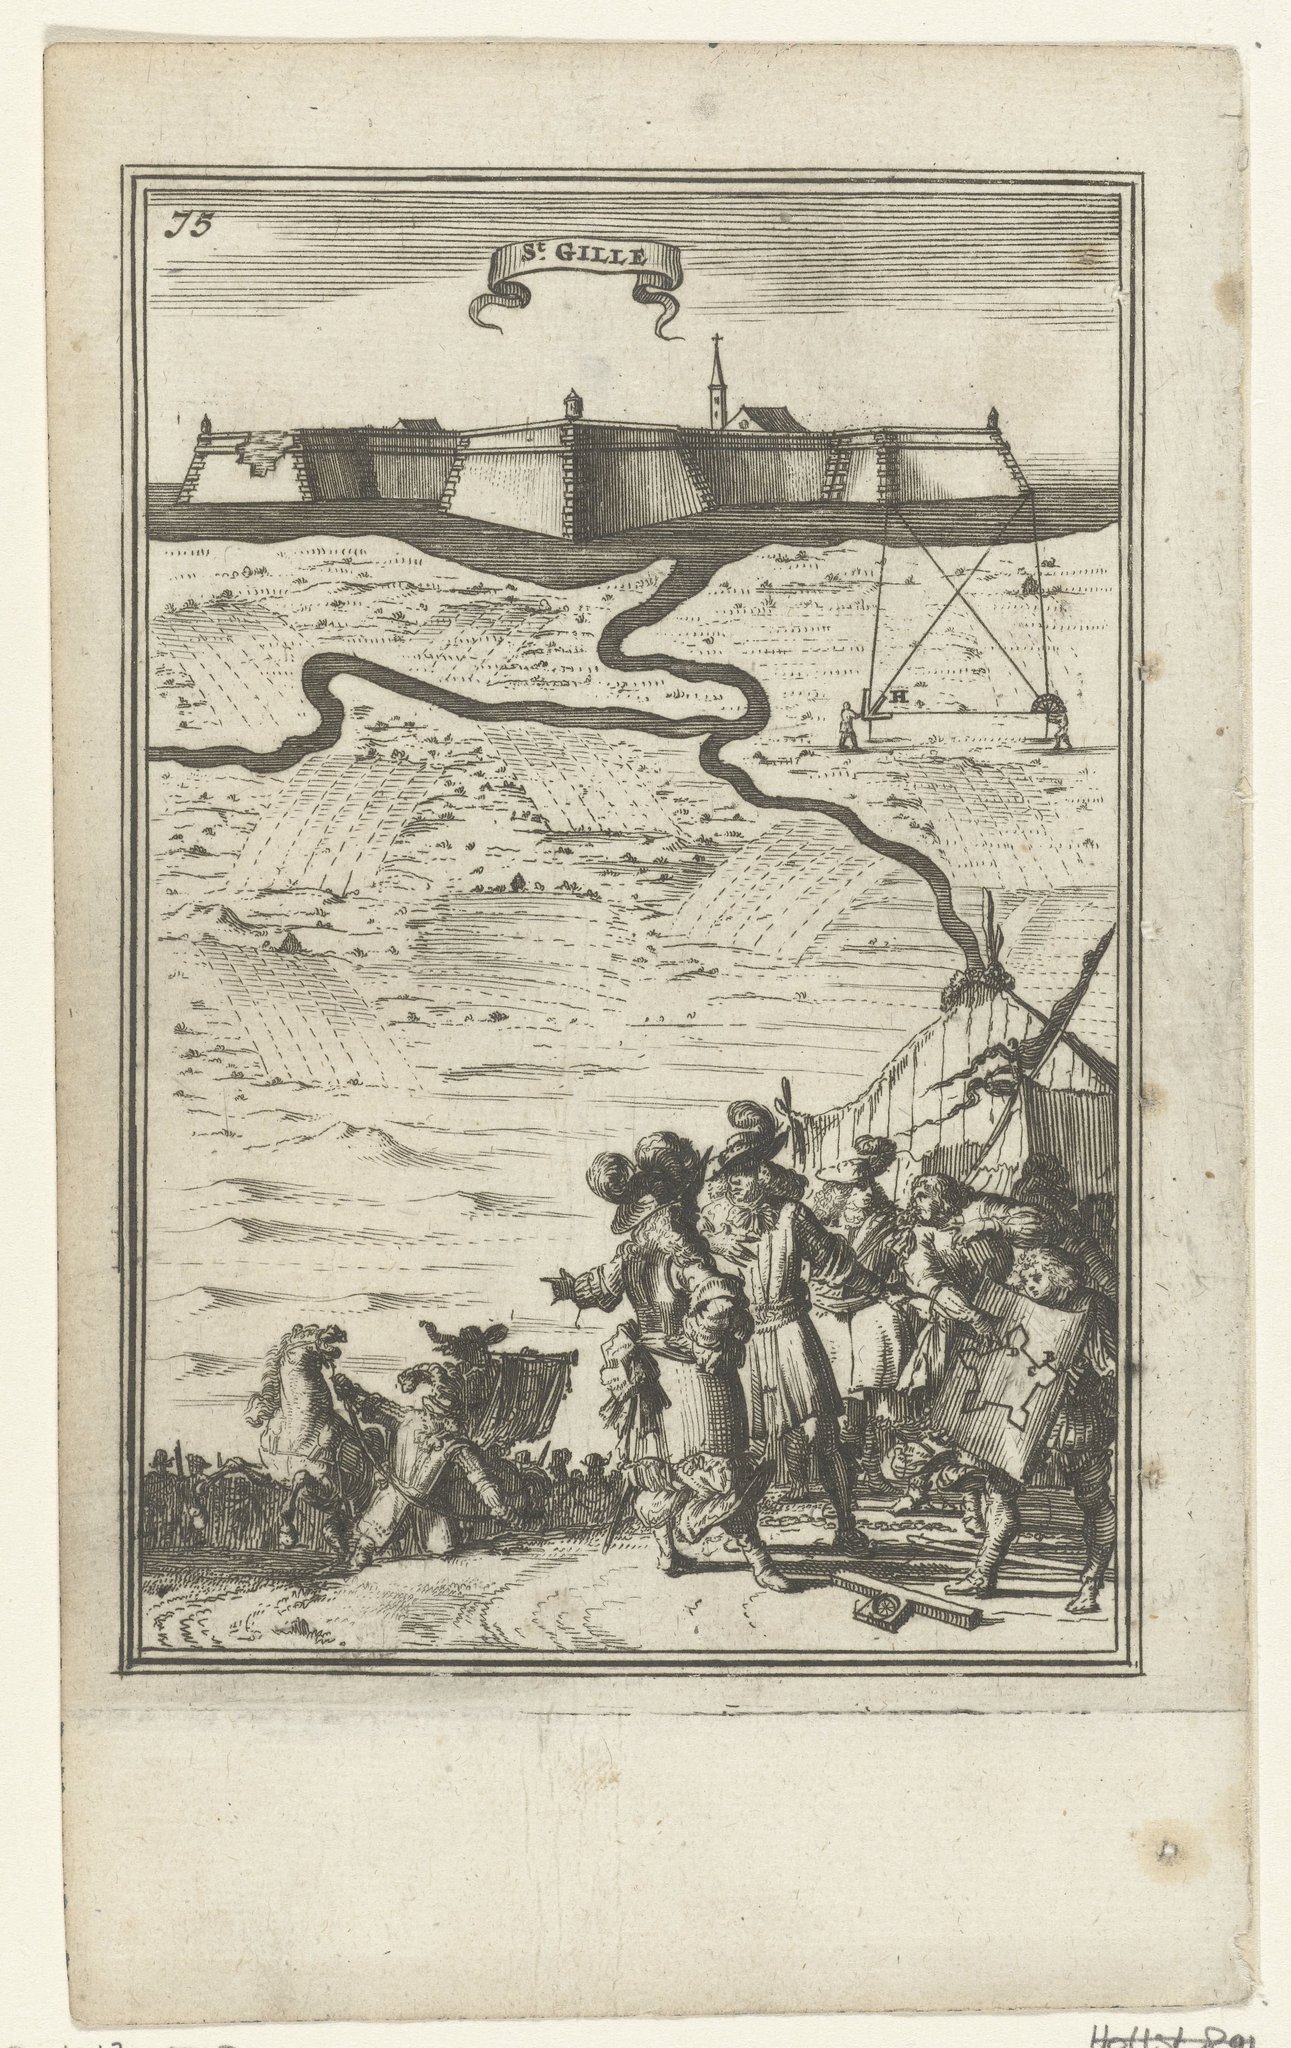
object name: book illustration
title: Illustratie voor 'Den Arbeid van Mars' van Allain Manesson Mallet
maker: romeyn de hooghe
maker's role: draughtsman, goldsmith, painter, print maker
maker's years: 1645-1708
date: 1672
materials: paper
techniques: engraving, etching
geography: amsterdam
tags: river, fortifications, military engineering, officer, prospect of city, town panorama, silhouette of city, mathematics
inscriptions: collector's mark: Lugt 2228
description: Gezicht op een stad aan een rivier ('St. Gille'); bij de muren voeren twee mannen metingen uit. Daaronder enkele officieren bij een kaart van een vesting, fort of versterking. In de hoek linksboven het cijfer 75 (= het nummer van de pagina in het boek waartegenover de illustratie geplaatst is).